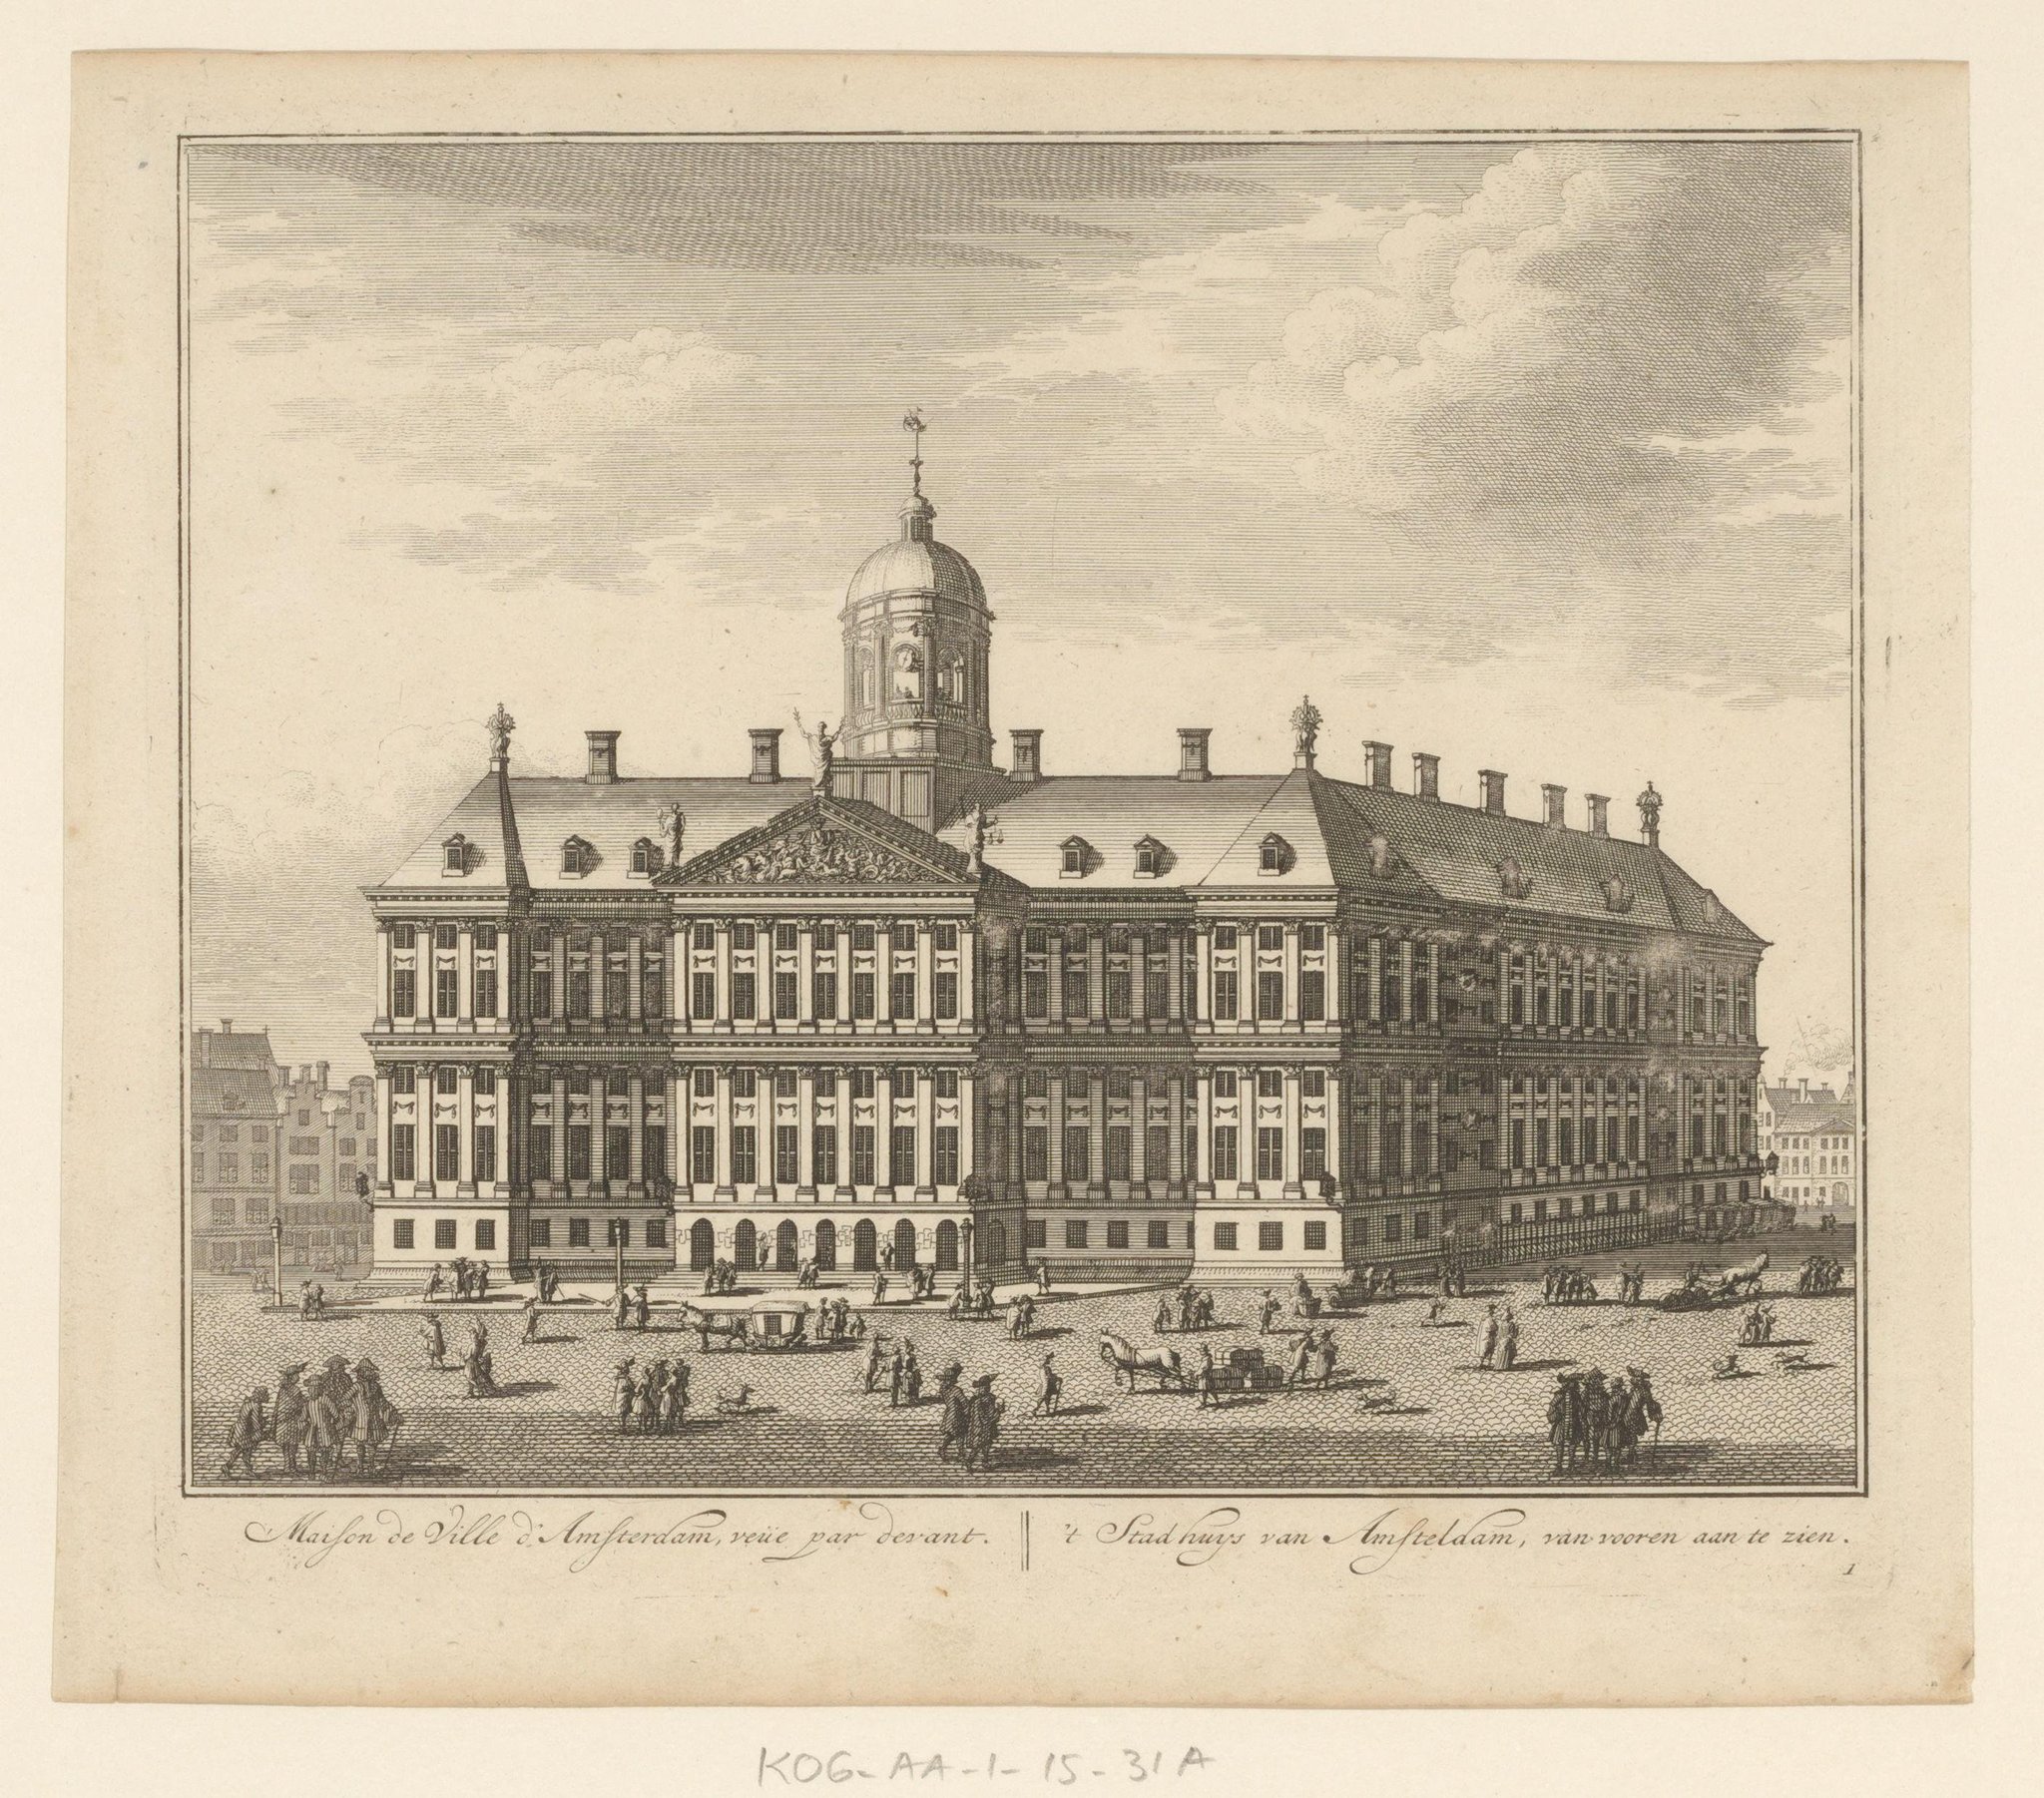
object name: print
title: Maison de Ville d'Amsterdam, veüe par devant / 't Stadhuys van Amsteldam, van vooren aan te zien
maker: Anonymous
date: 1700-1799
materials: paper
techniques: etching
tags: square, place, circus, etc., city-view in general; 'veduta', townhall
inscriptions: inscription: ‘Legaat Joh. M. Coffeng / 1966’, collector's mark: ‘15D,31 A/B’ Lugt 1641b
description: Onderwerpsrubriek binnen de Atlas Amsterdam: Nieuwe Stadhuis, als Stadhuis, op de Dam.